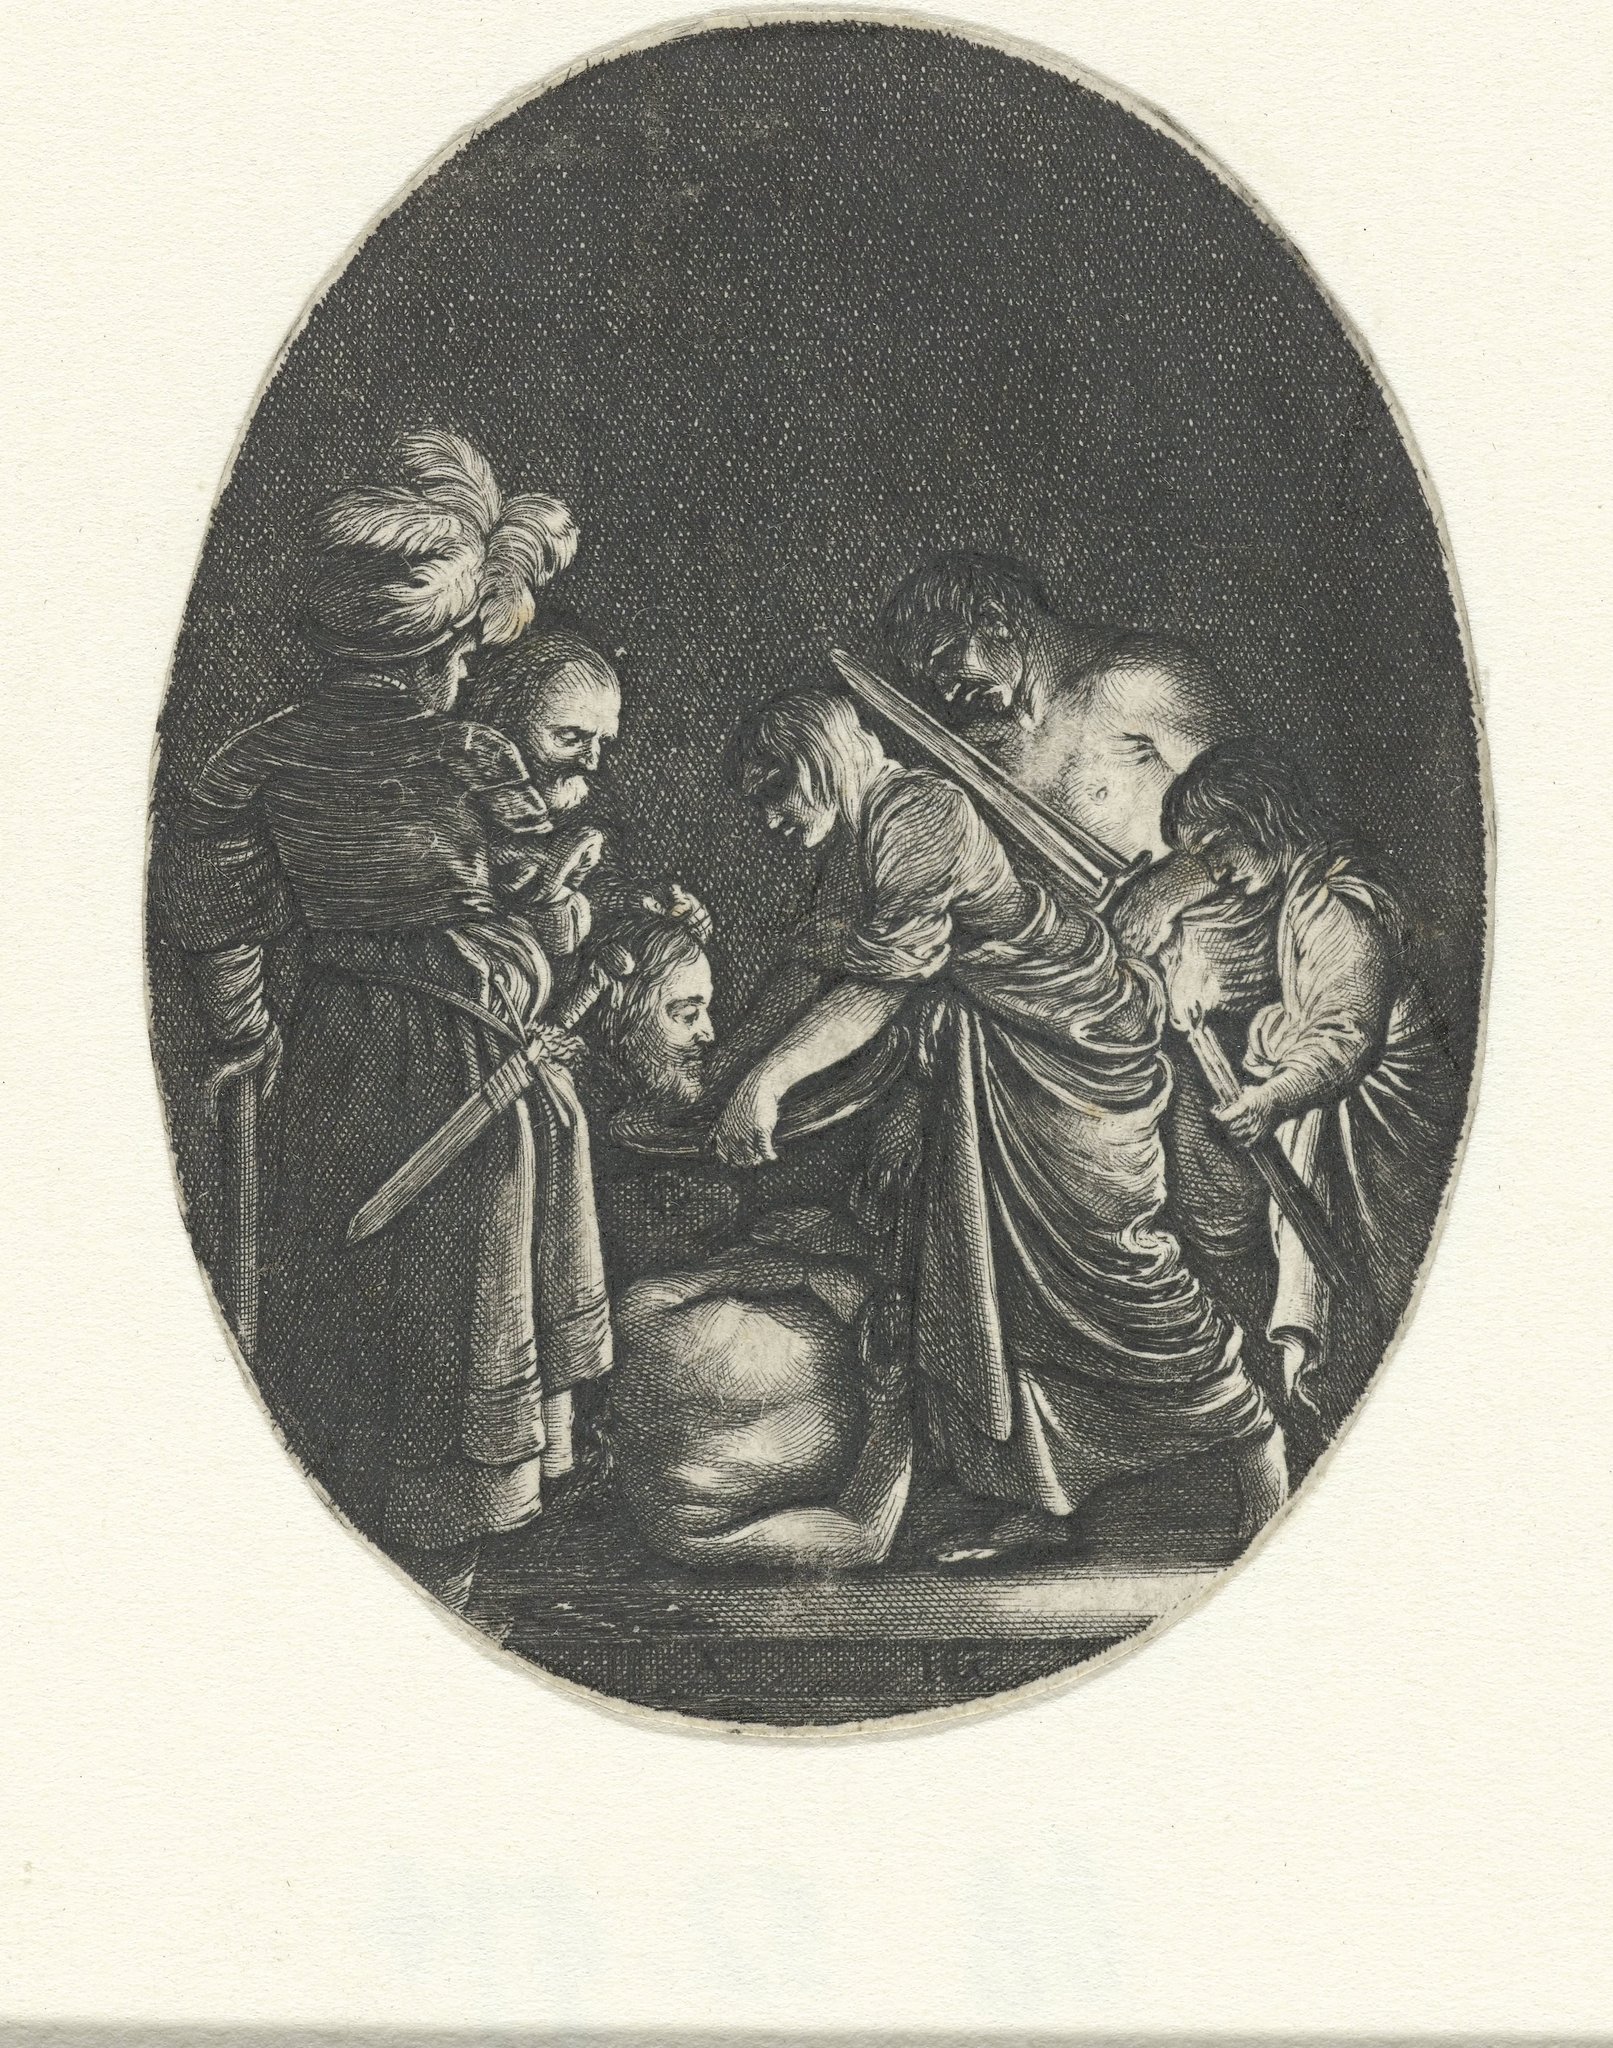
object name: print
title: Presentatie van het hoofd van Johannes de Doper aan Salome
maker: hendrick goudt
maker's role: draughtsman, print maker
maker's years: 1581-1648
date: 1591-1648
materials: paper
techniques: engraving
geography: rome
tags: salome is given the head of john the baptist by the executioner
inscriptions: collector's mark: Lugt 240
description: In een ovale lijst: de beul presenteert het hoofd van Johannes de Doper aan Salome, die een schotel vasthoudt. Naar een schilderij van Adam Elsheimer.